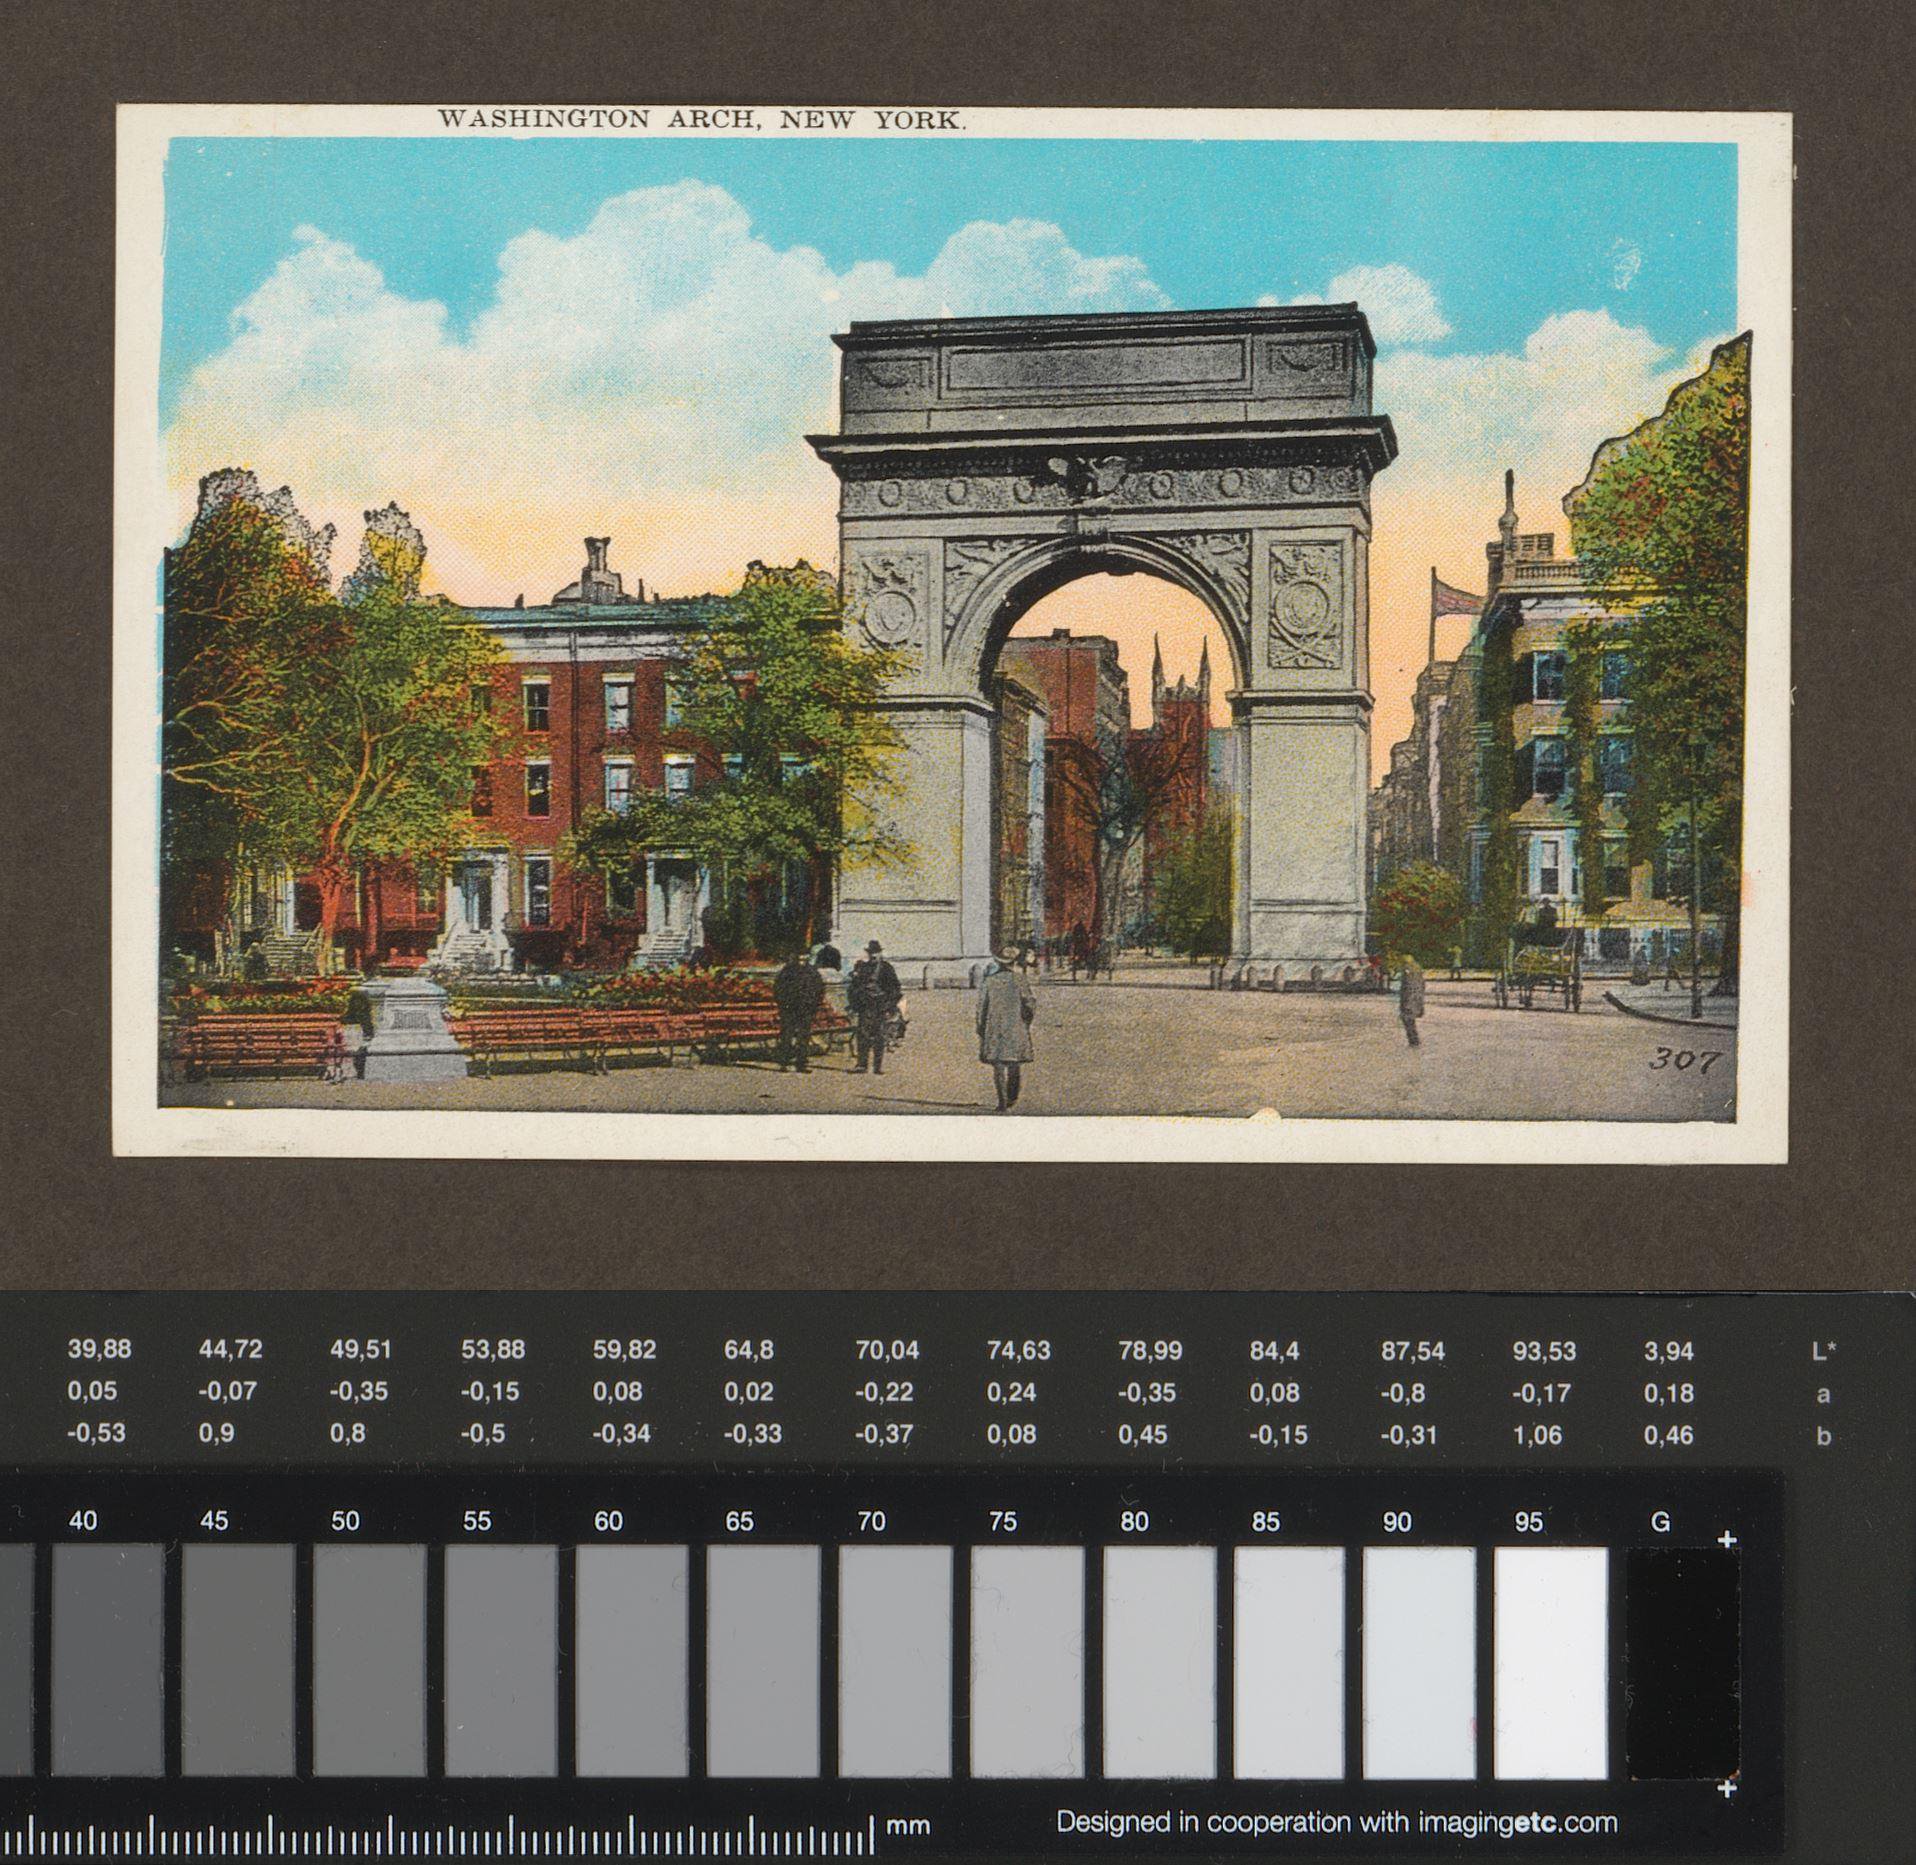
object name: album leaf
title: Washington Arch, New York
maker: Anonymous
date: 1928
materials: paper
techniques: four-color autotype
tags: arch, archivolt ~ architecture, new york (city)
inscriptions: number: ‘307’